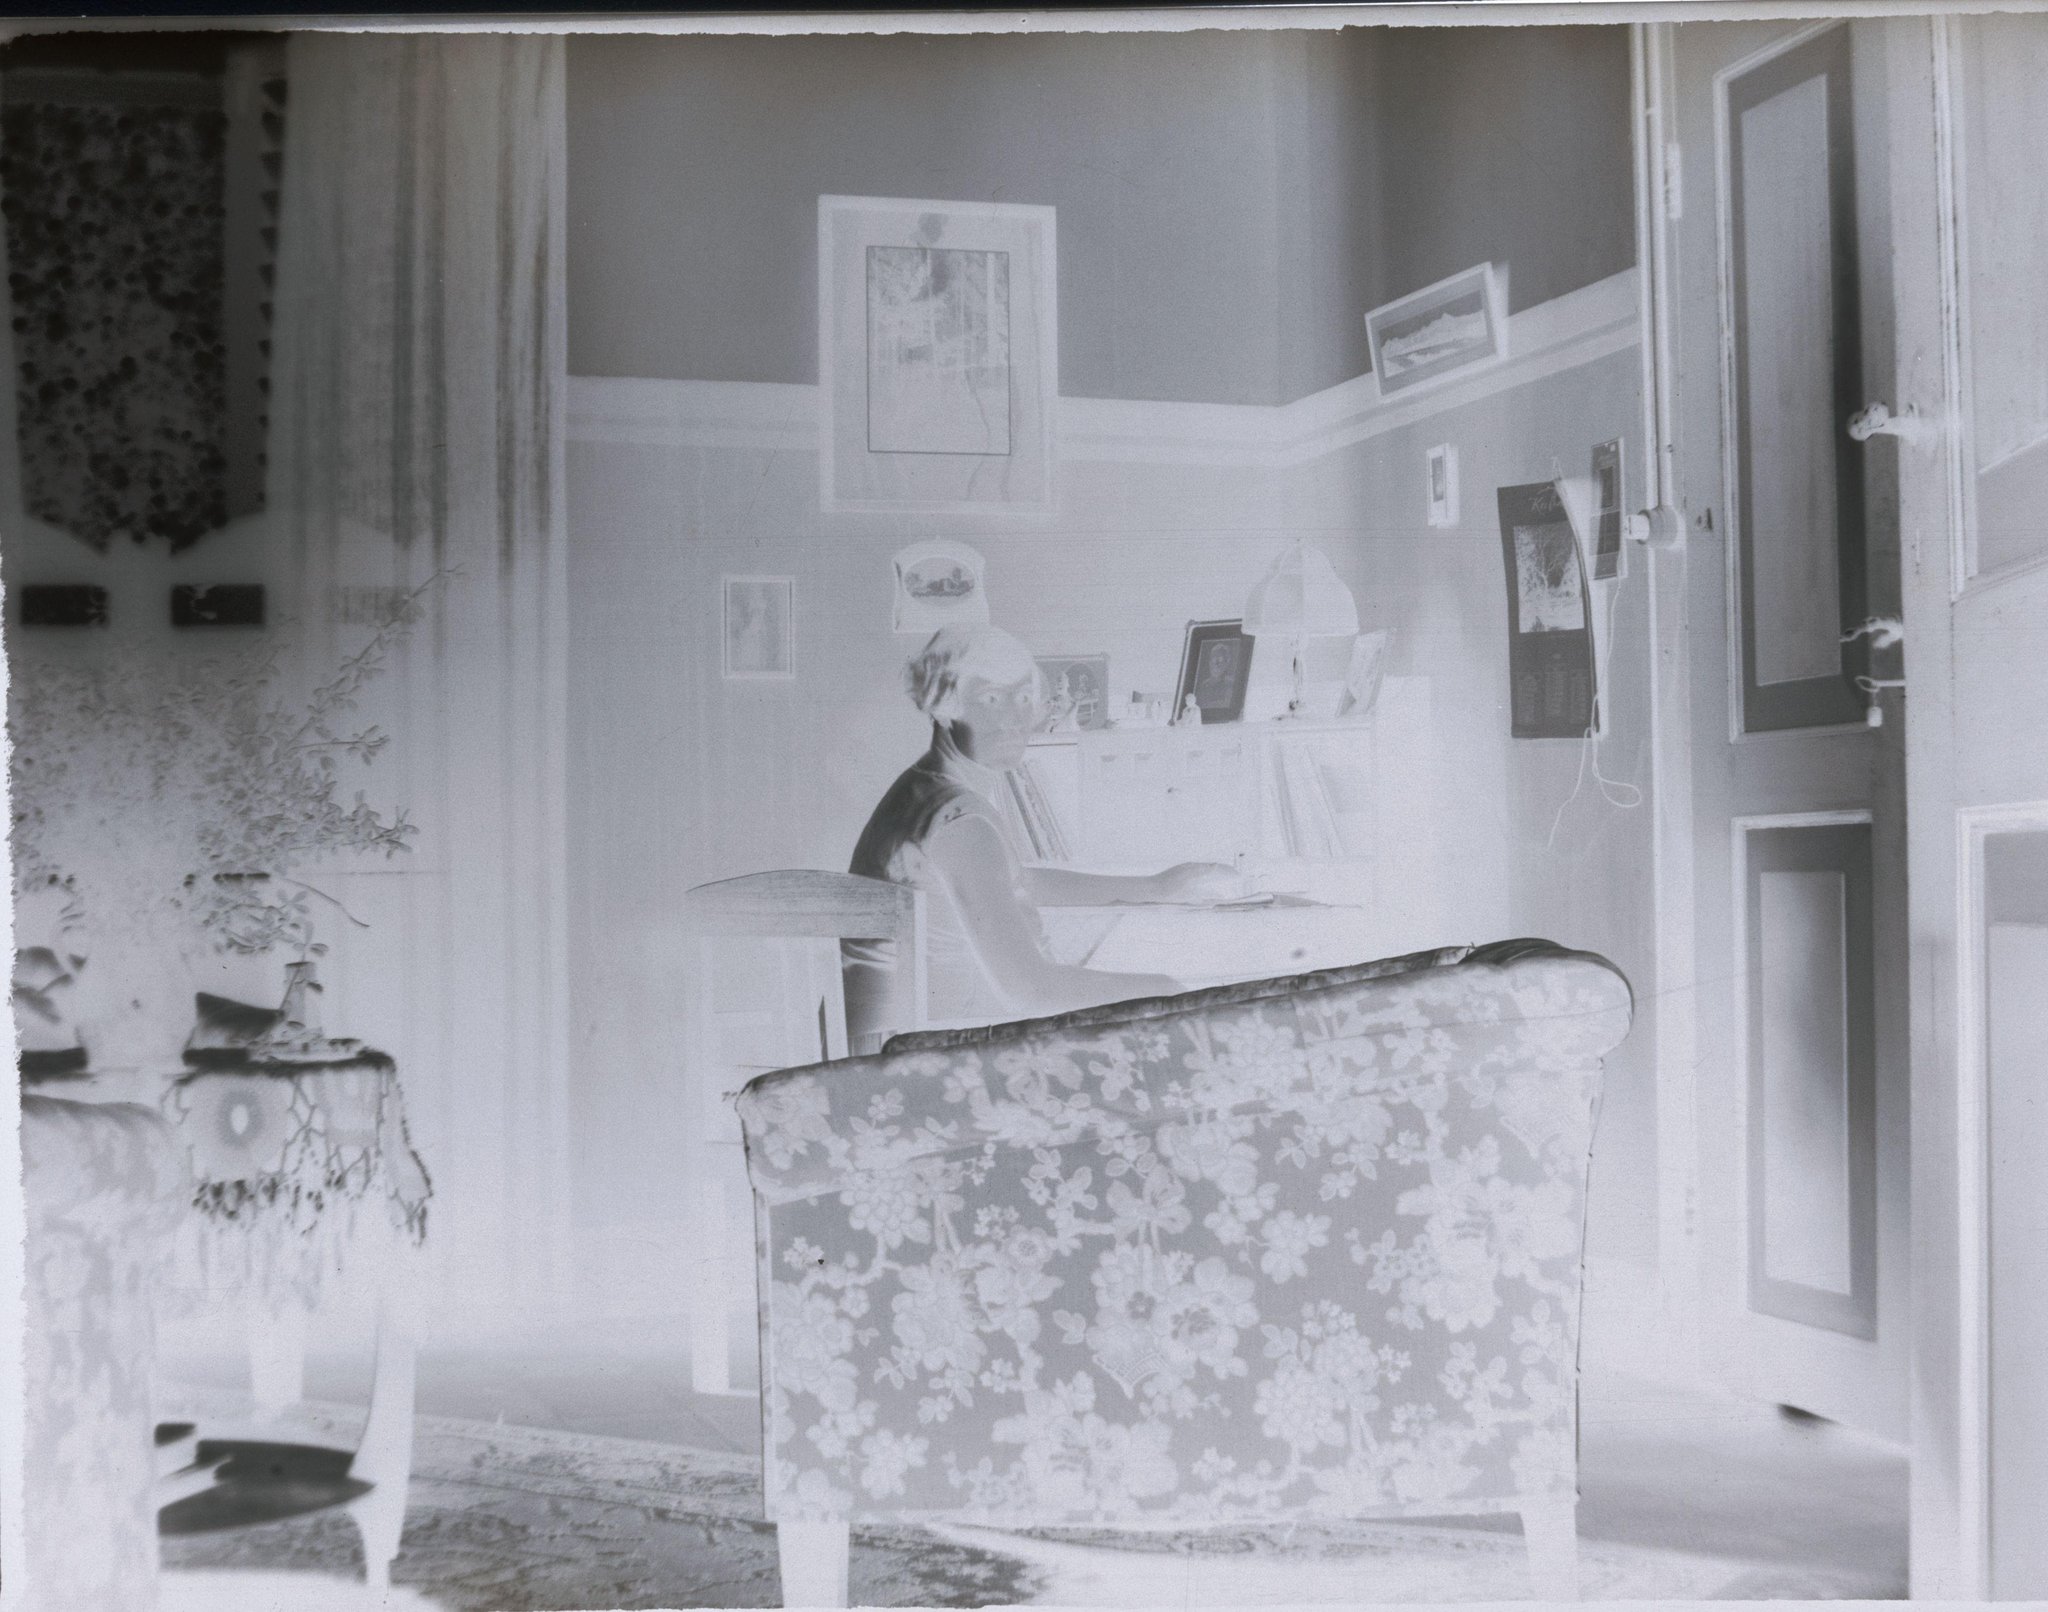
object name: negative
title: Vrouw aangeduid als Suzi zittend op een stoel in een kamer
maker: Anonymous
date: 1928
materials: film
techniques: gelatin silver negative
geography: dutch east indies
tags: interior of the house, dutch east indies, the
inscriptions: number: ‘8’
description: Onderdeel van Kodak negatievenalbum met 35 foto's van een familie in Nederlands-Indië.